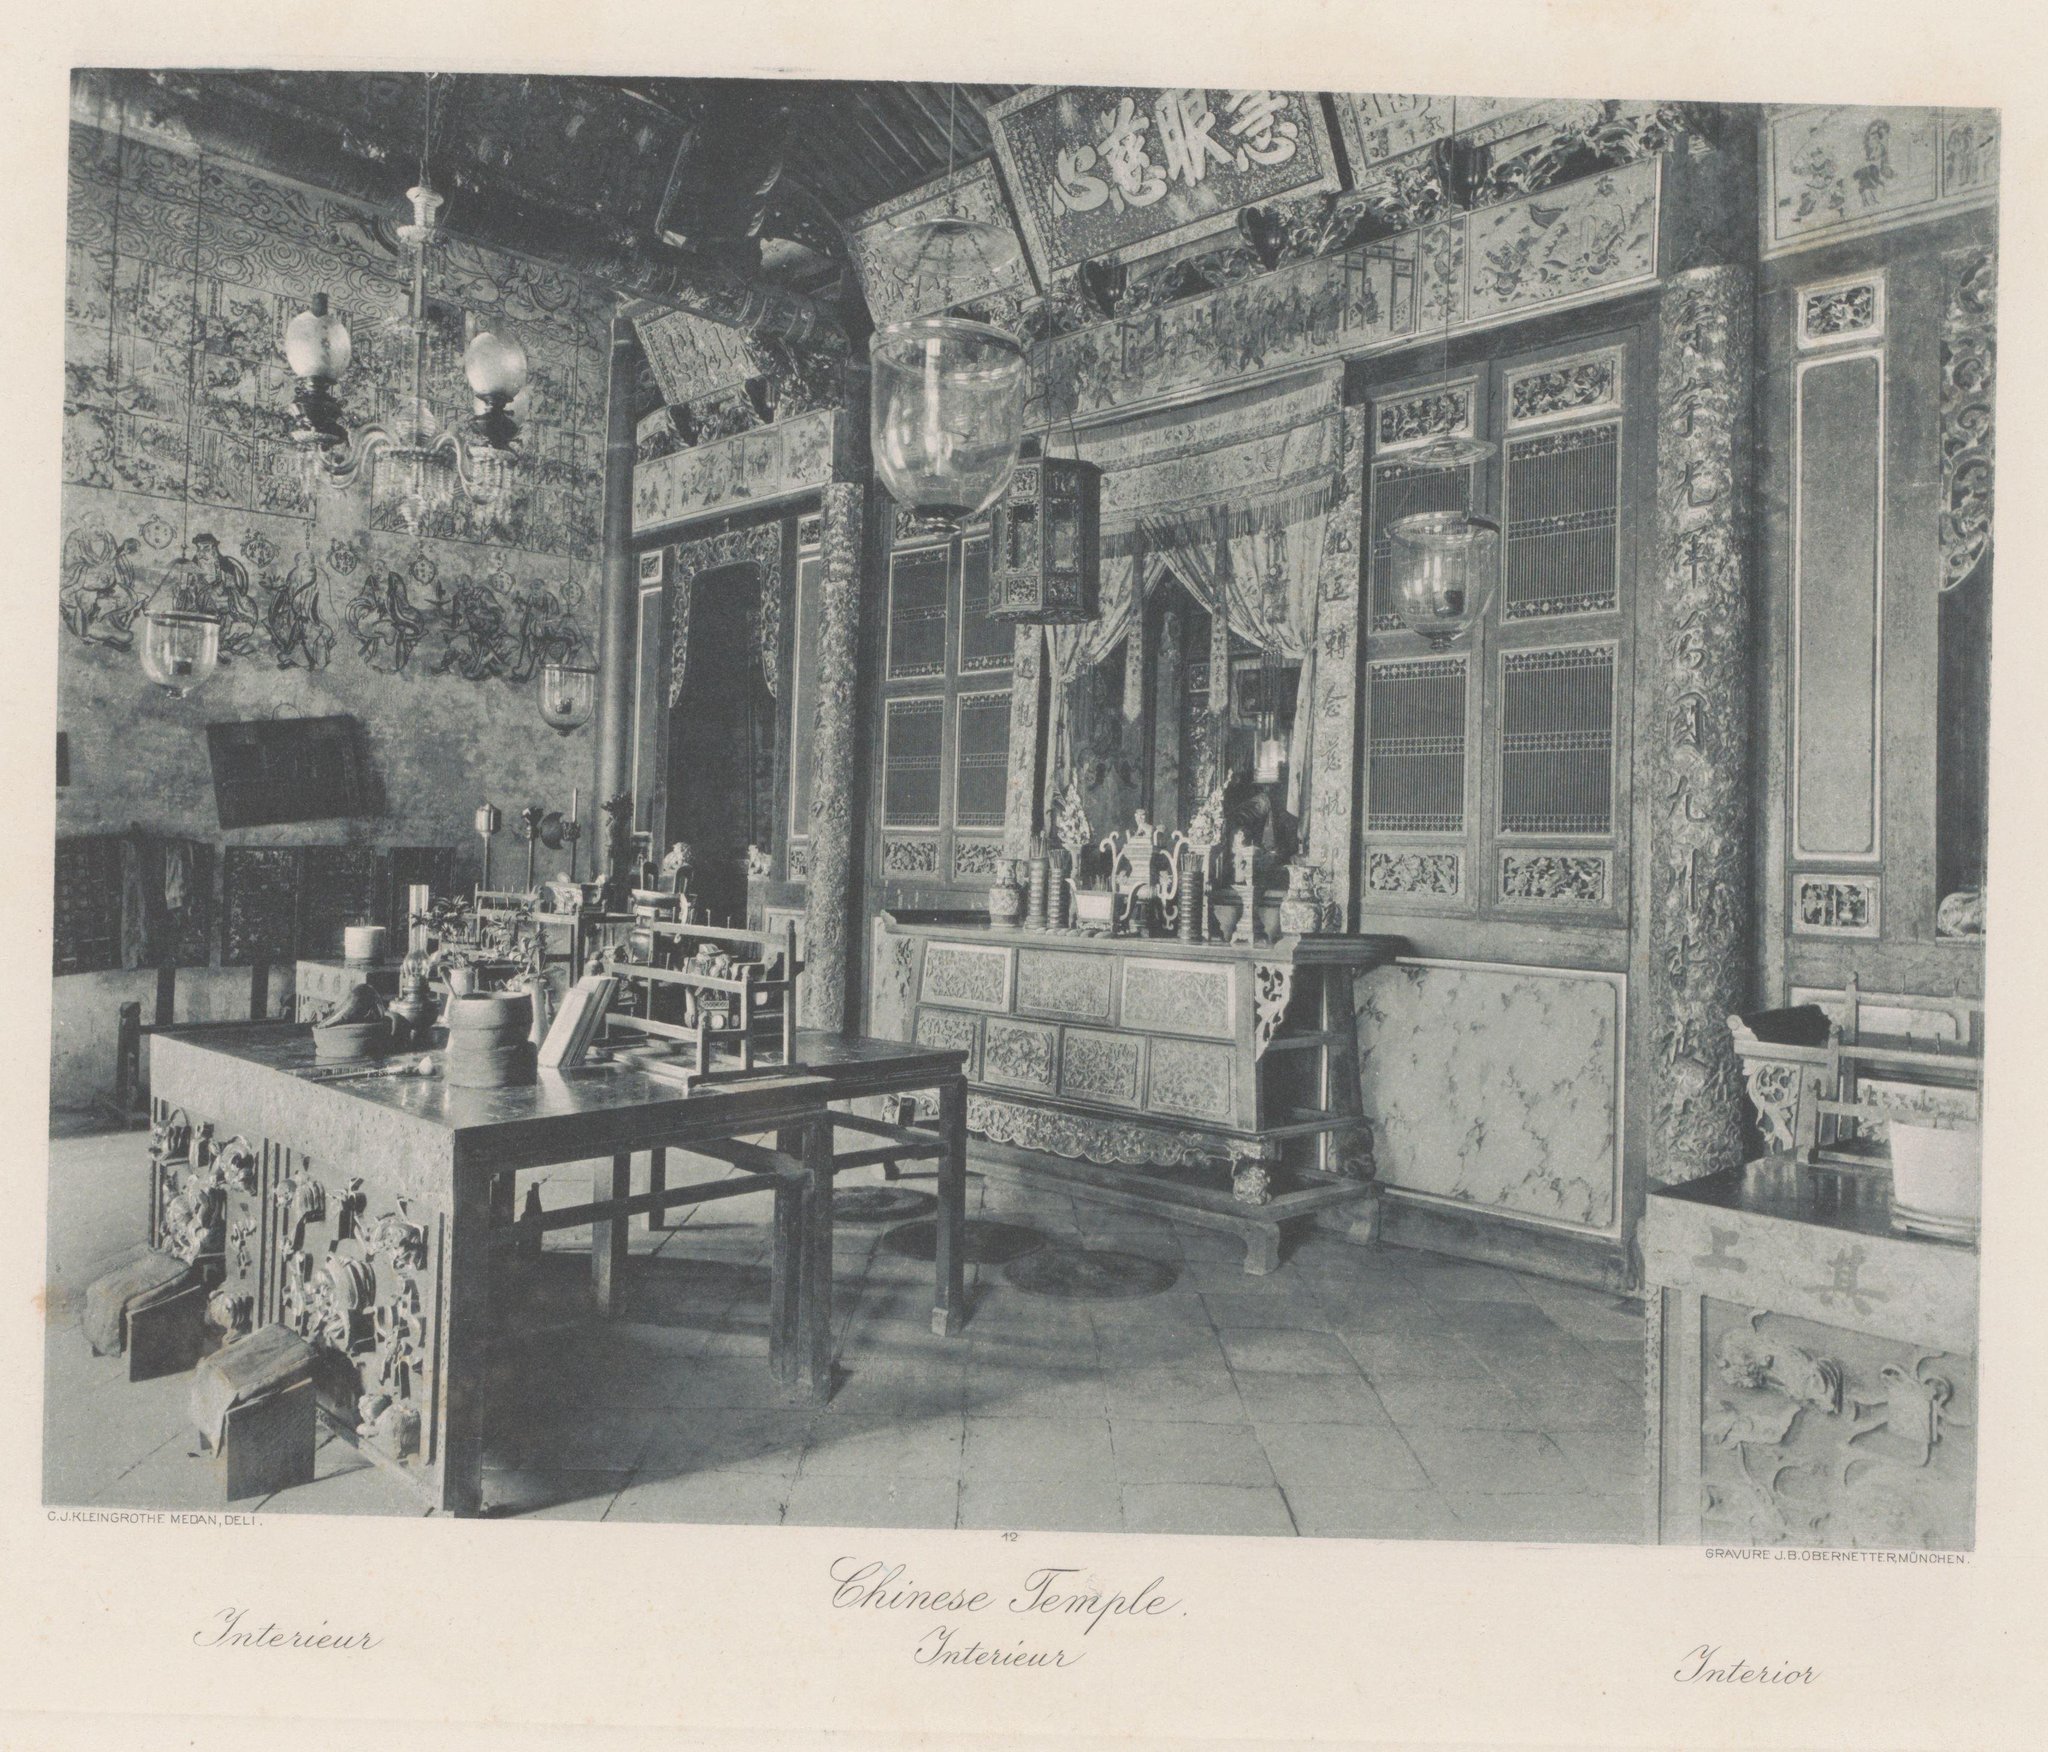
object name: photomechanical print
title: Interieur van een Chinese tempel, vermoedelijk in Kloempang op Sumatra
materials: paper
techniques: photoaquatint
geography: munich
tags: temple, shrine ~ hinduism, buddhism, jainism, sumatra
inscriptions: number: ‘12’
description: Onderdeel van Album met heliogravures van Sumatra's oostkust.